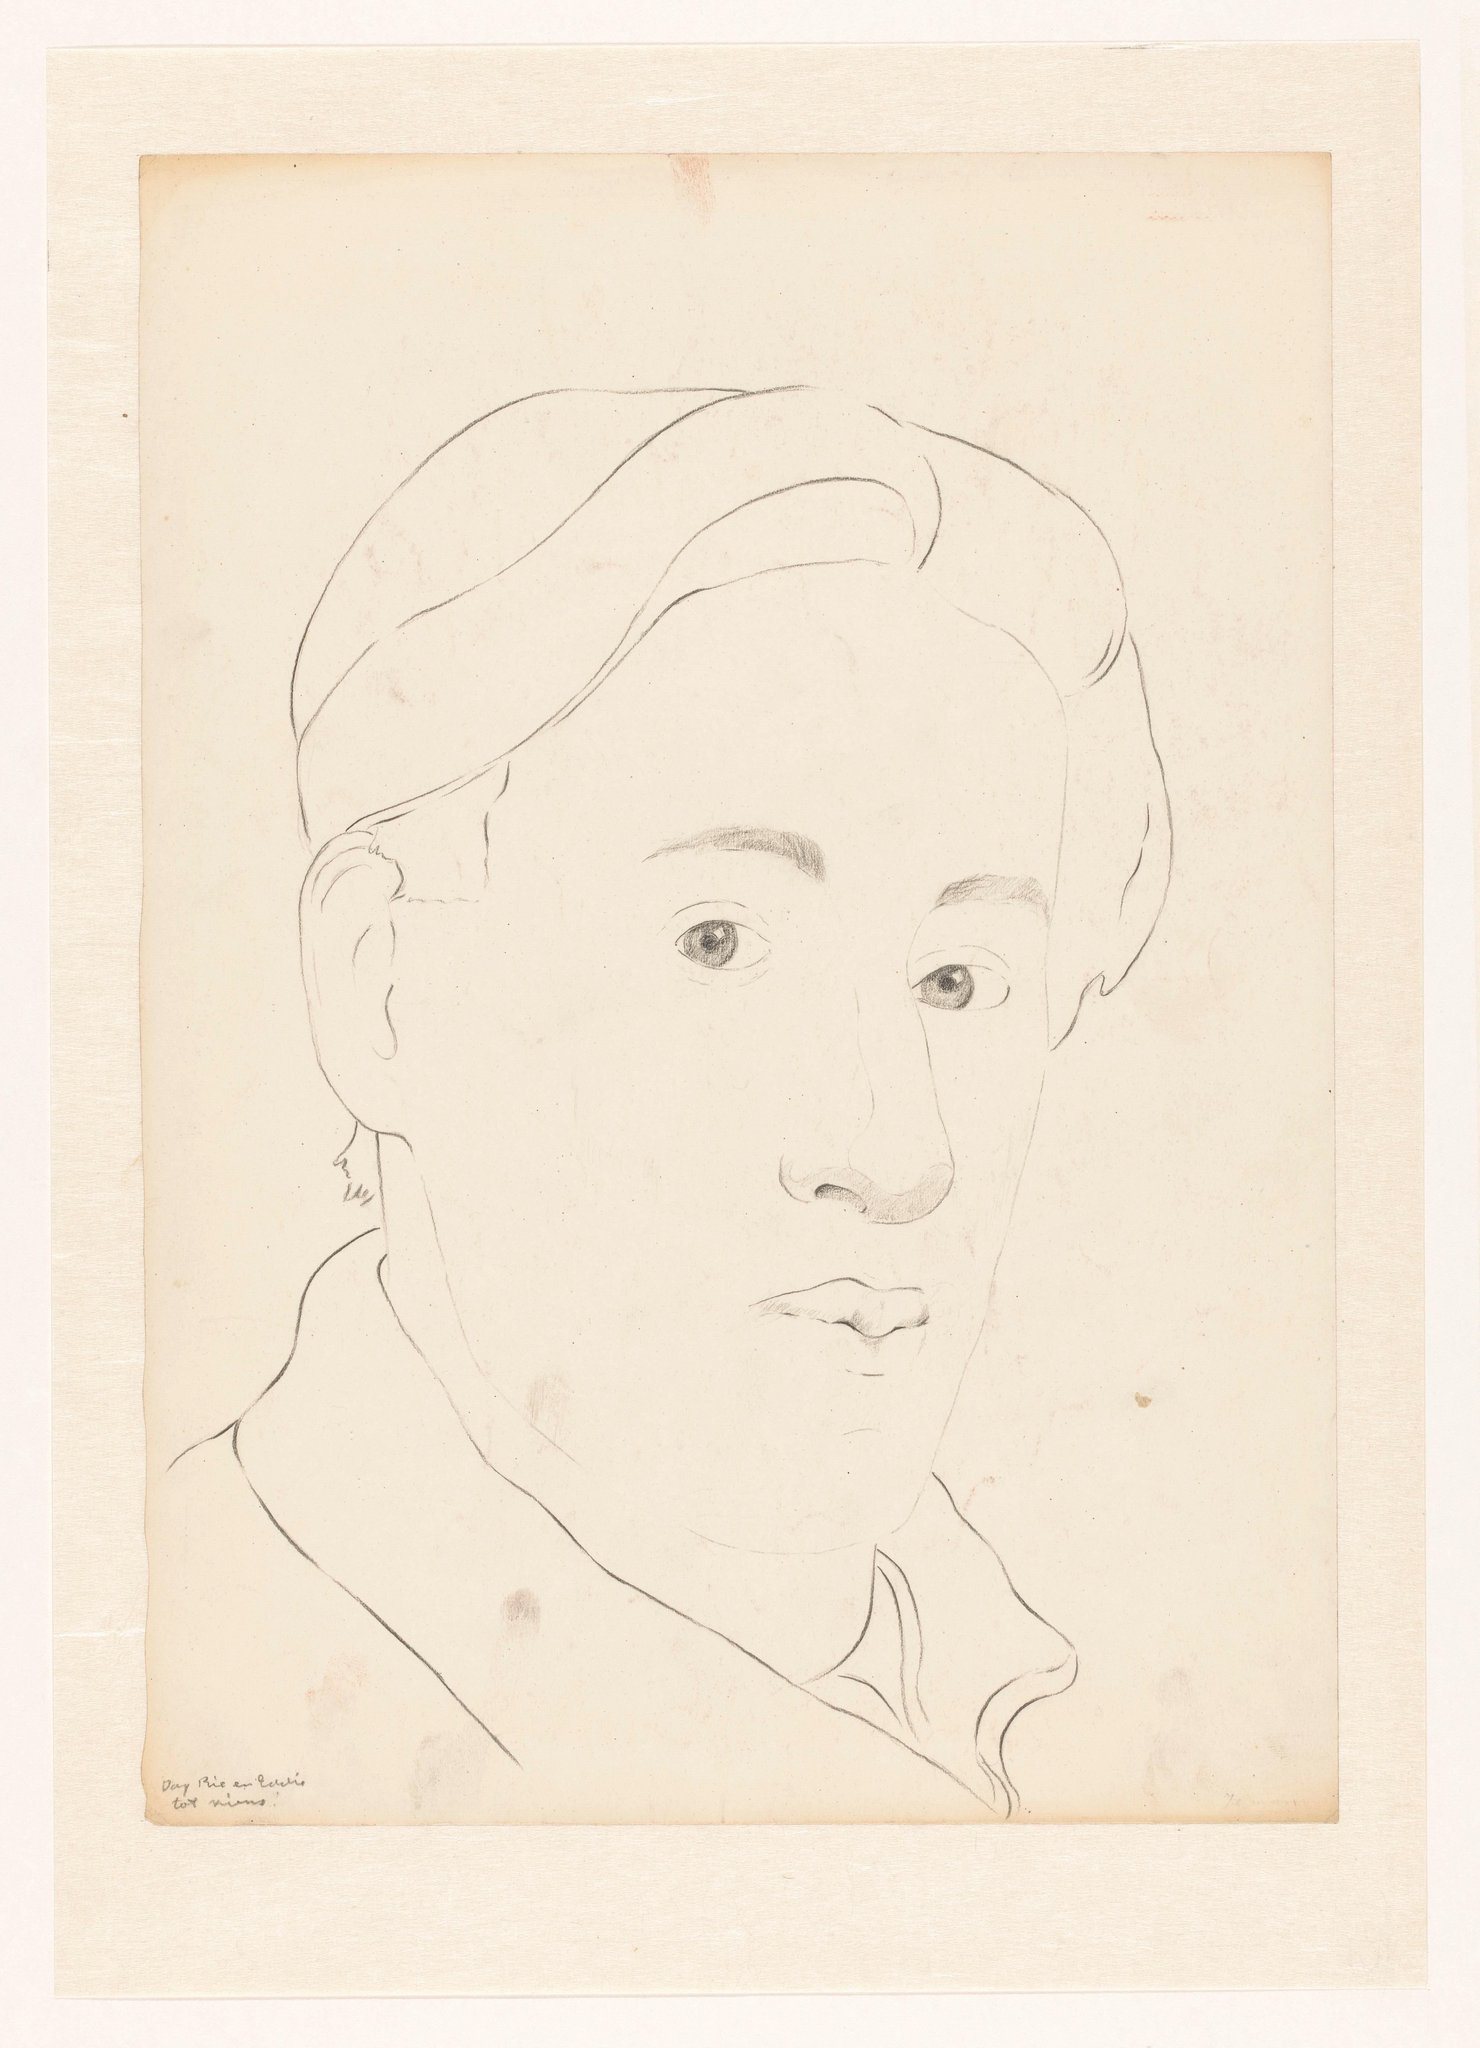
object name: drawing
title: Zelfportret op lineaire wijze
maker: cor van teeseling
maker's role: draughtsman, sculptor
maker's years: 1915-1942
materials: paper, pencil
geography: amsterdam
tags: amsterdam, draughtsman, sculptor, cor van teeseling, historical persons, prisoner in cell or locked place, portrait, self-portrait of draughtsman, netherlands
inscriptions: inscription: ‘Dag Rie en Eddie / tot ziens’, inscription: ‘Dag Rie veel liefs Dag Eddie’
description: Zelfportret van Cor van Teeseling. Cor van Teeseling op lineaire wijze driekwart geportretteerd, zijn hoofd naar rechts gewend.